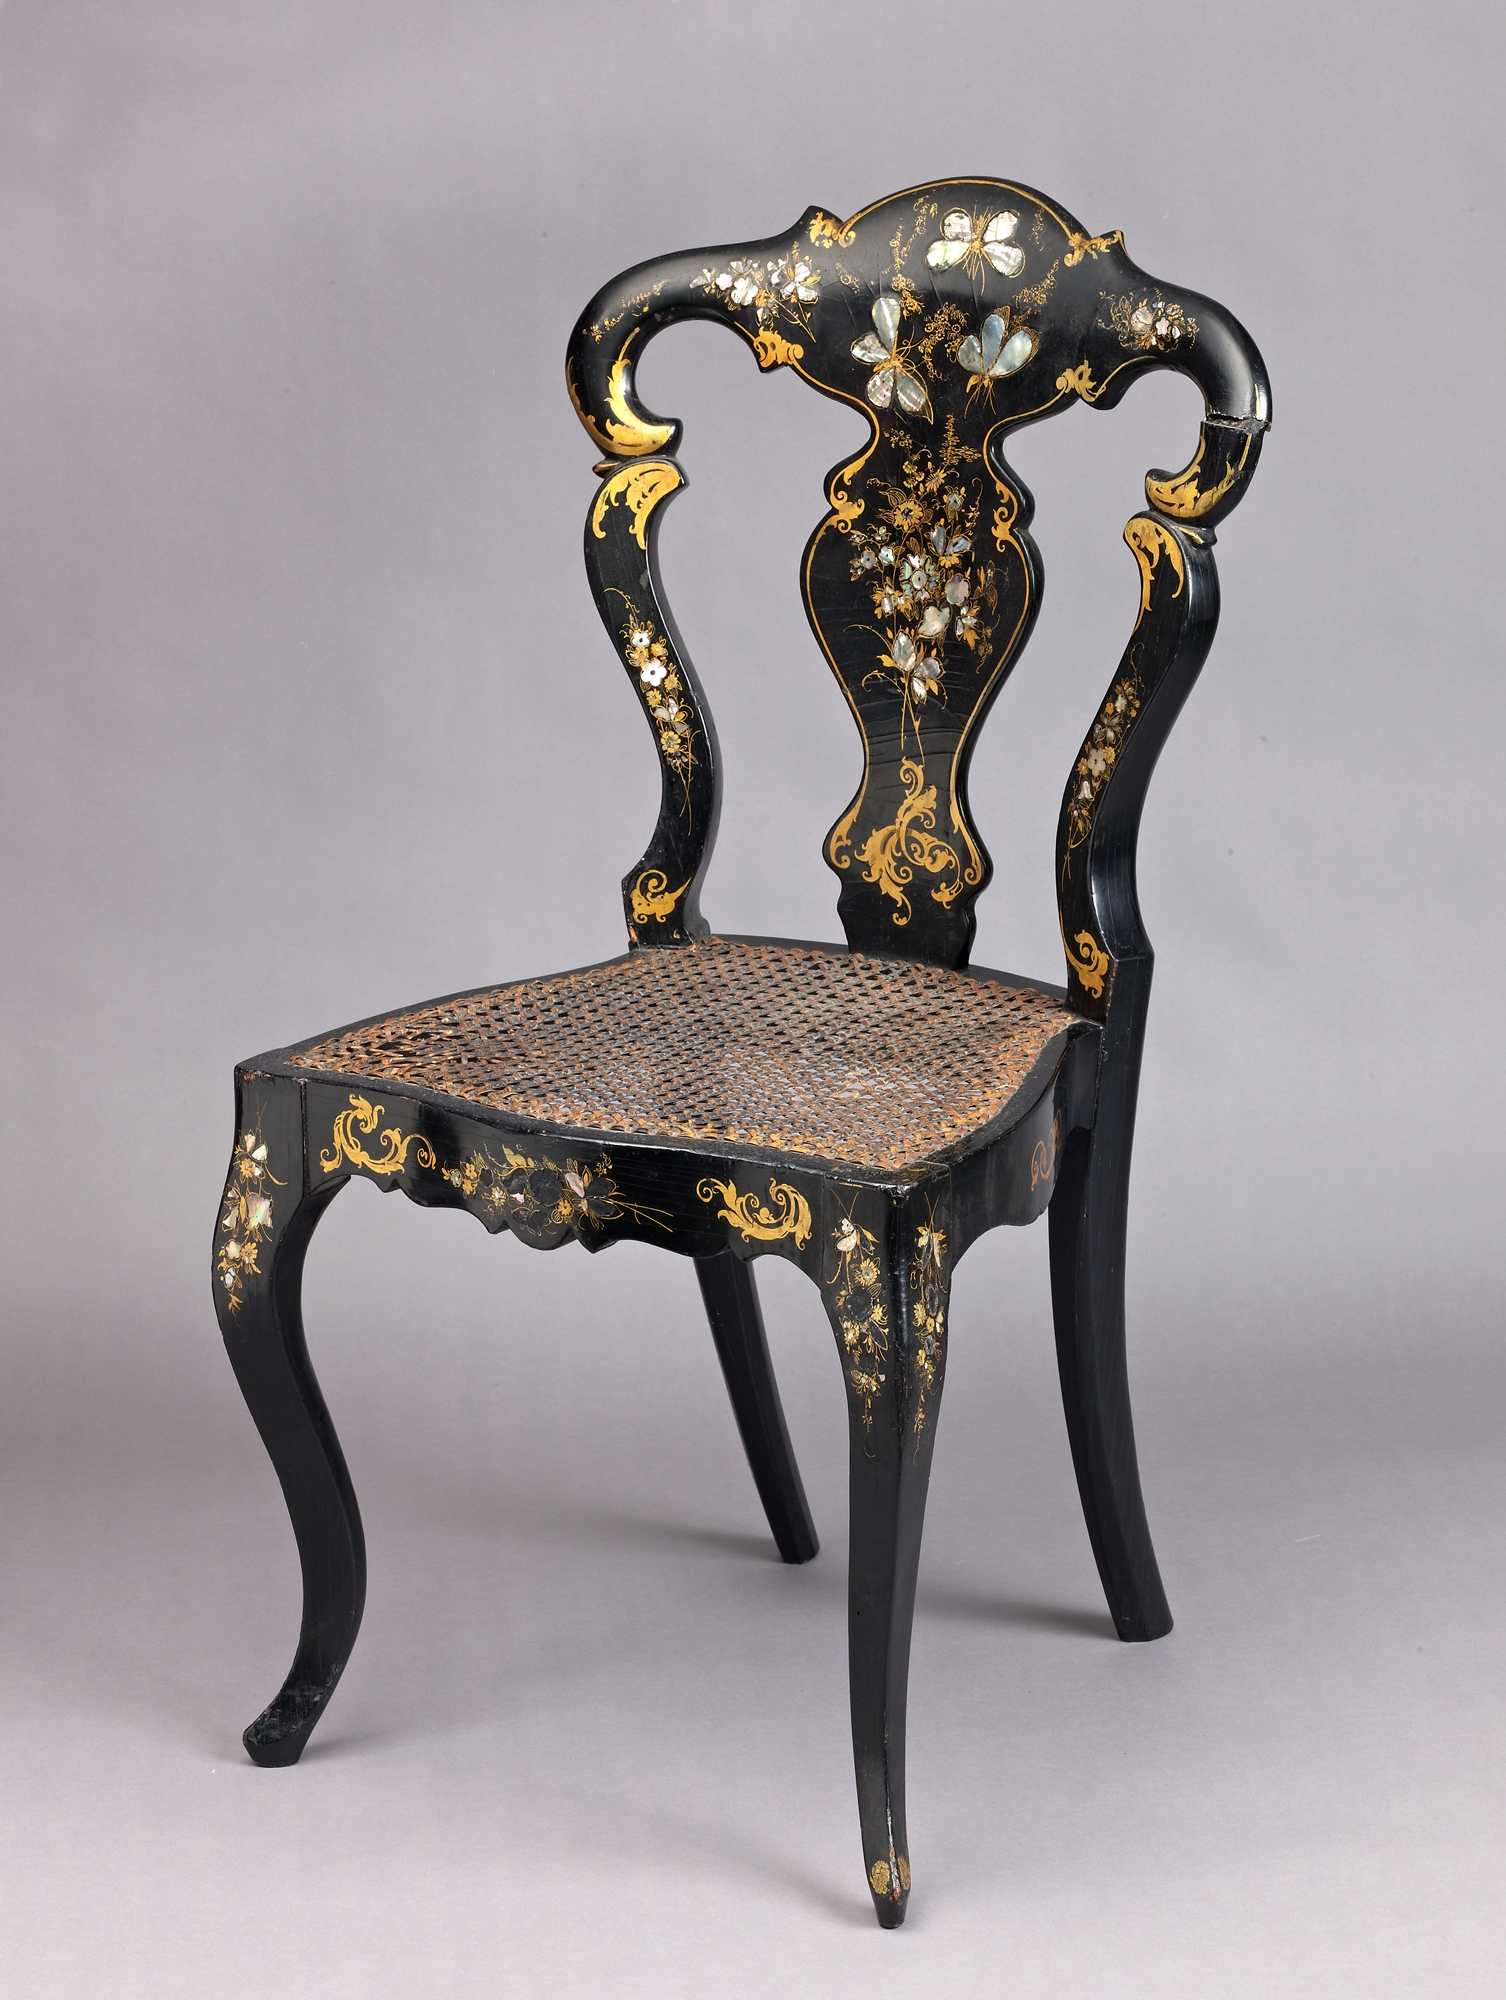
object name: chair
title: Papier-mâchè side chair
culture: british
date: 1830-1860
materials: lacquer, mother of pearl, paper, wood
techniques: caning, gilding, painting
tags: butterflies,flowers